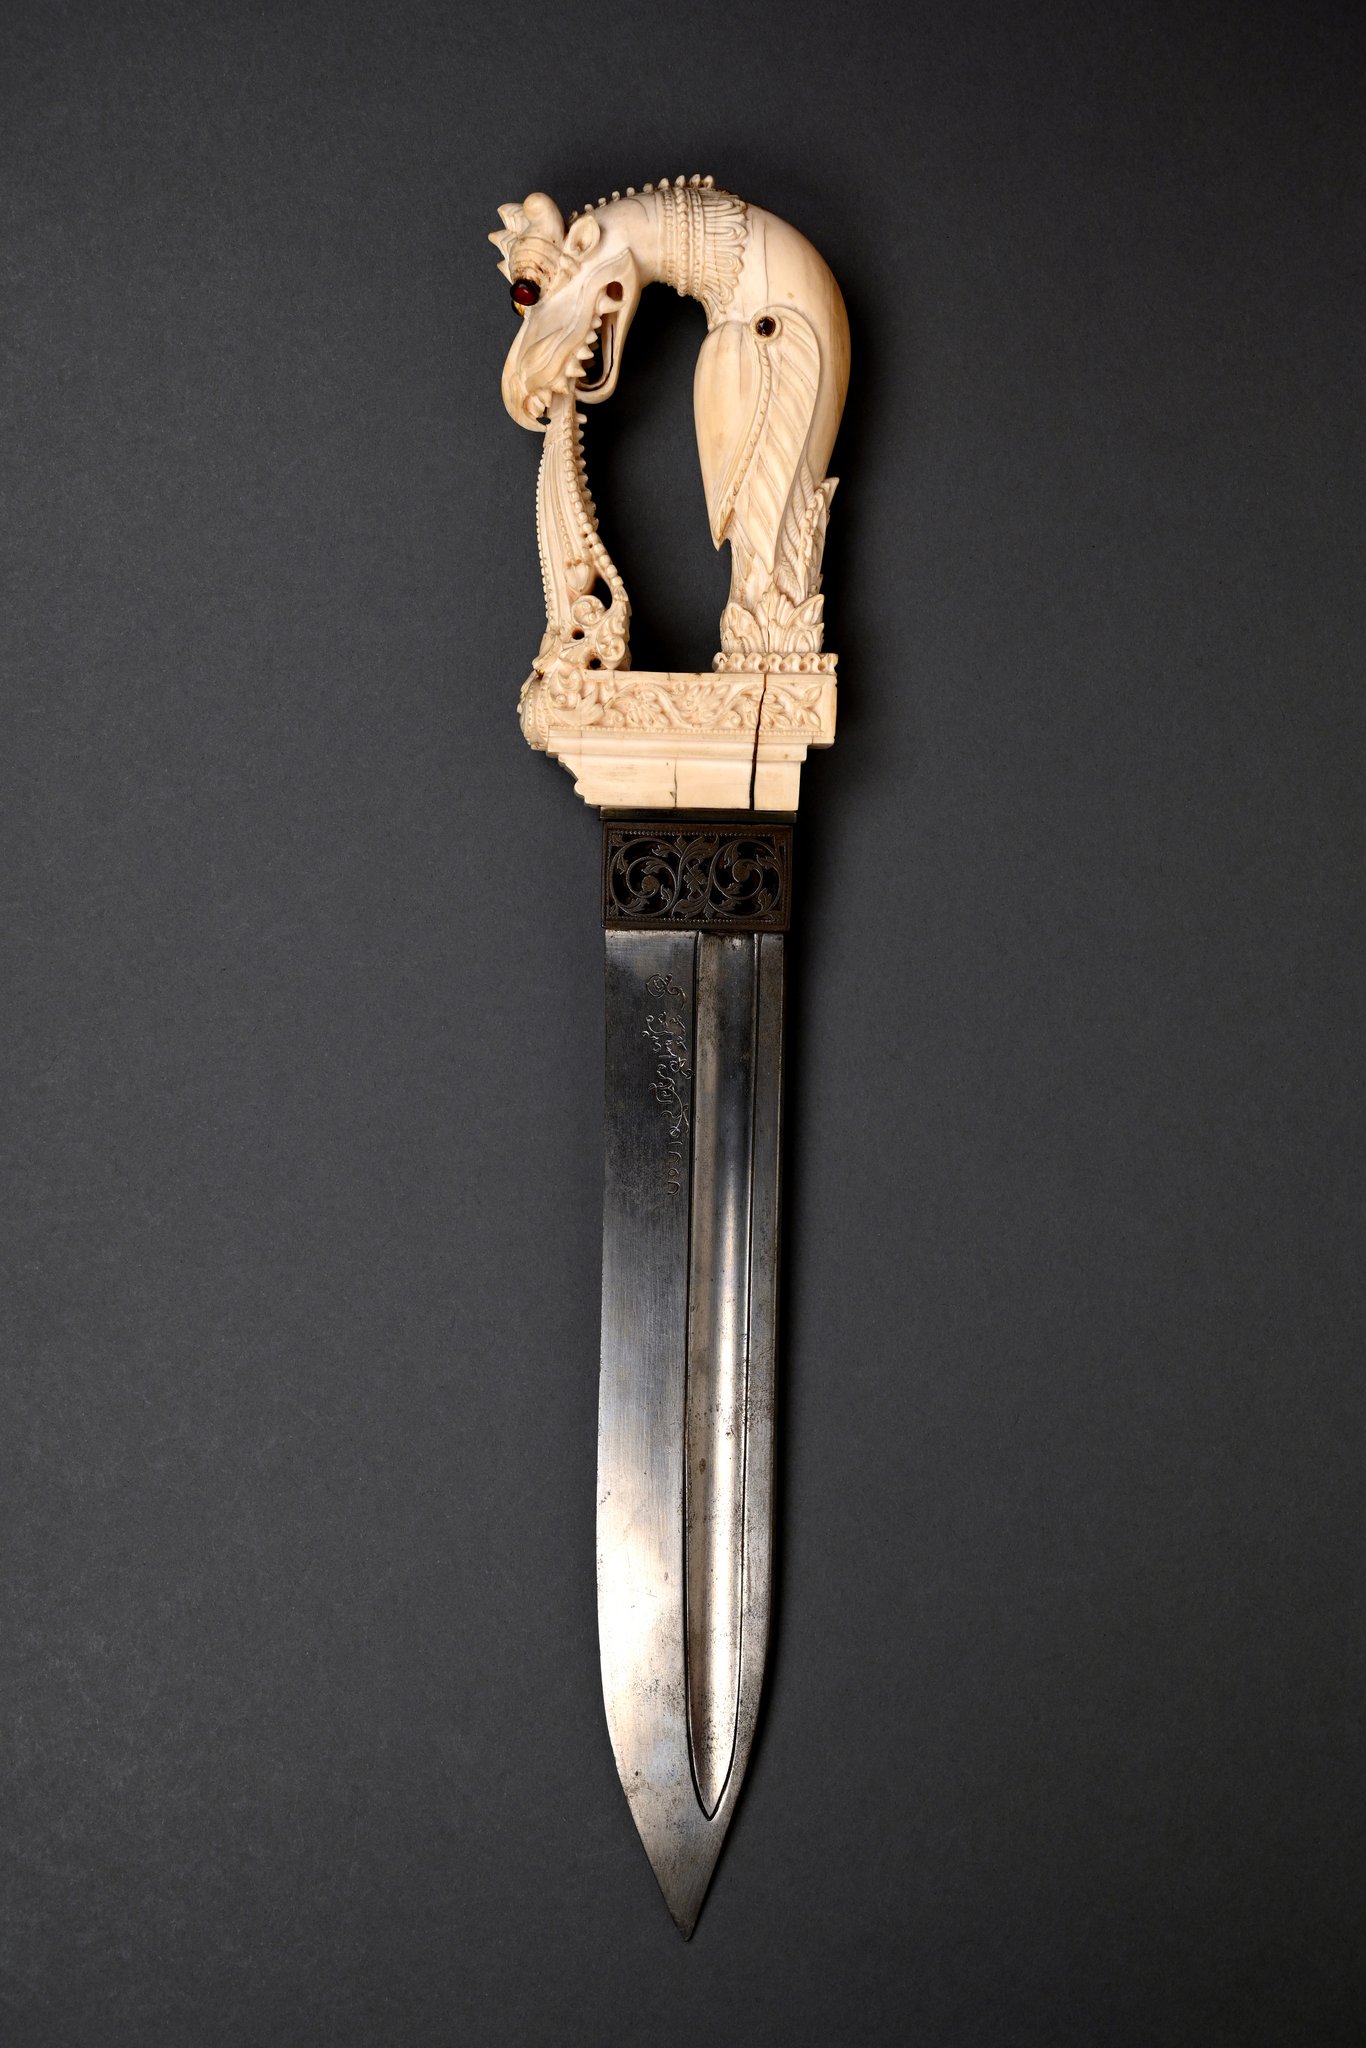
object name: dagger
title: Dagger with Yali Hilt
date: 1800-1850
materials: gemstone, glass, ivory, steel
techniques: carving, inlay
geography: india